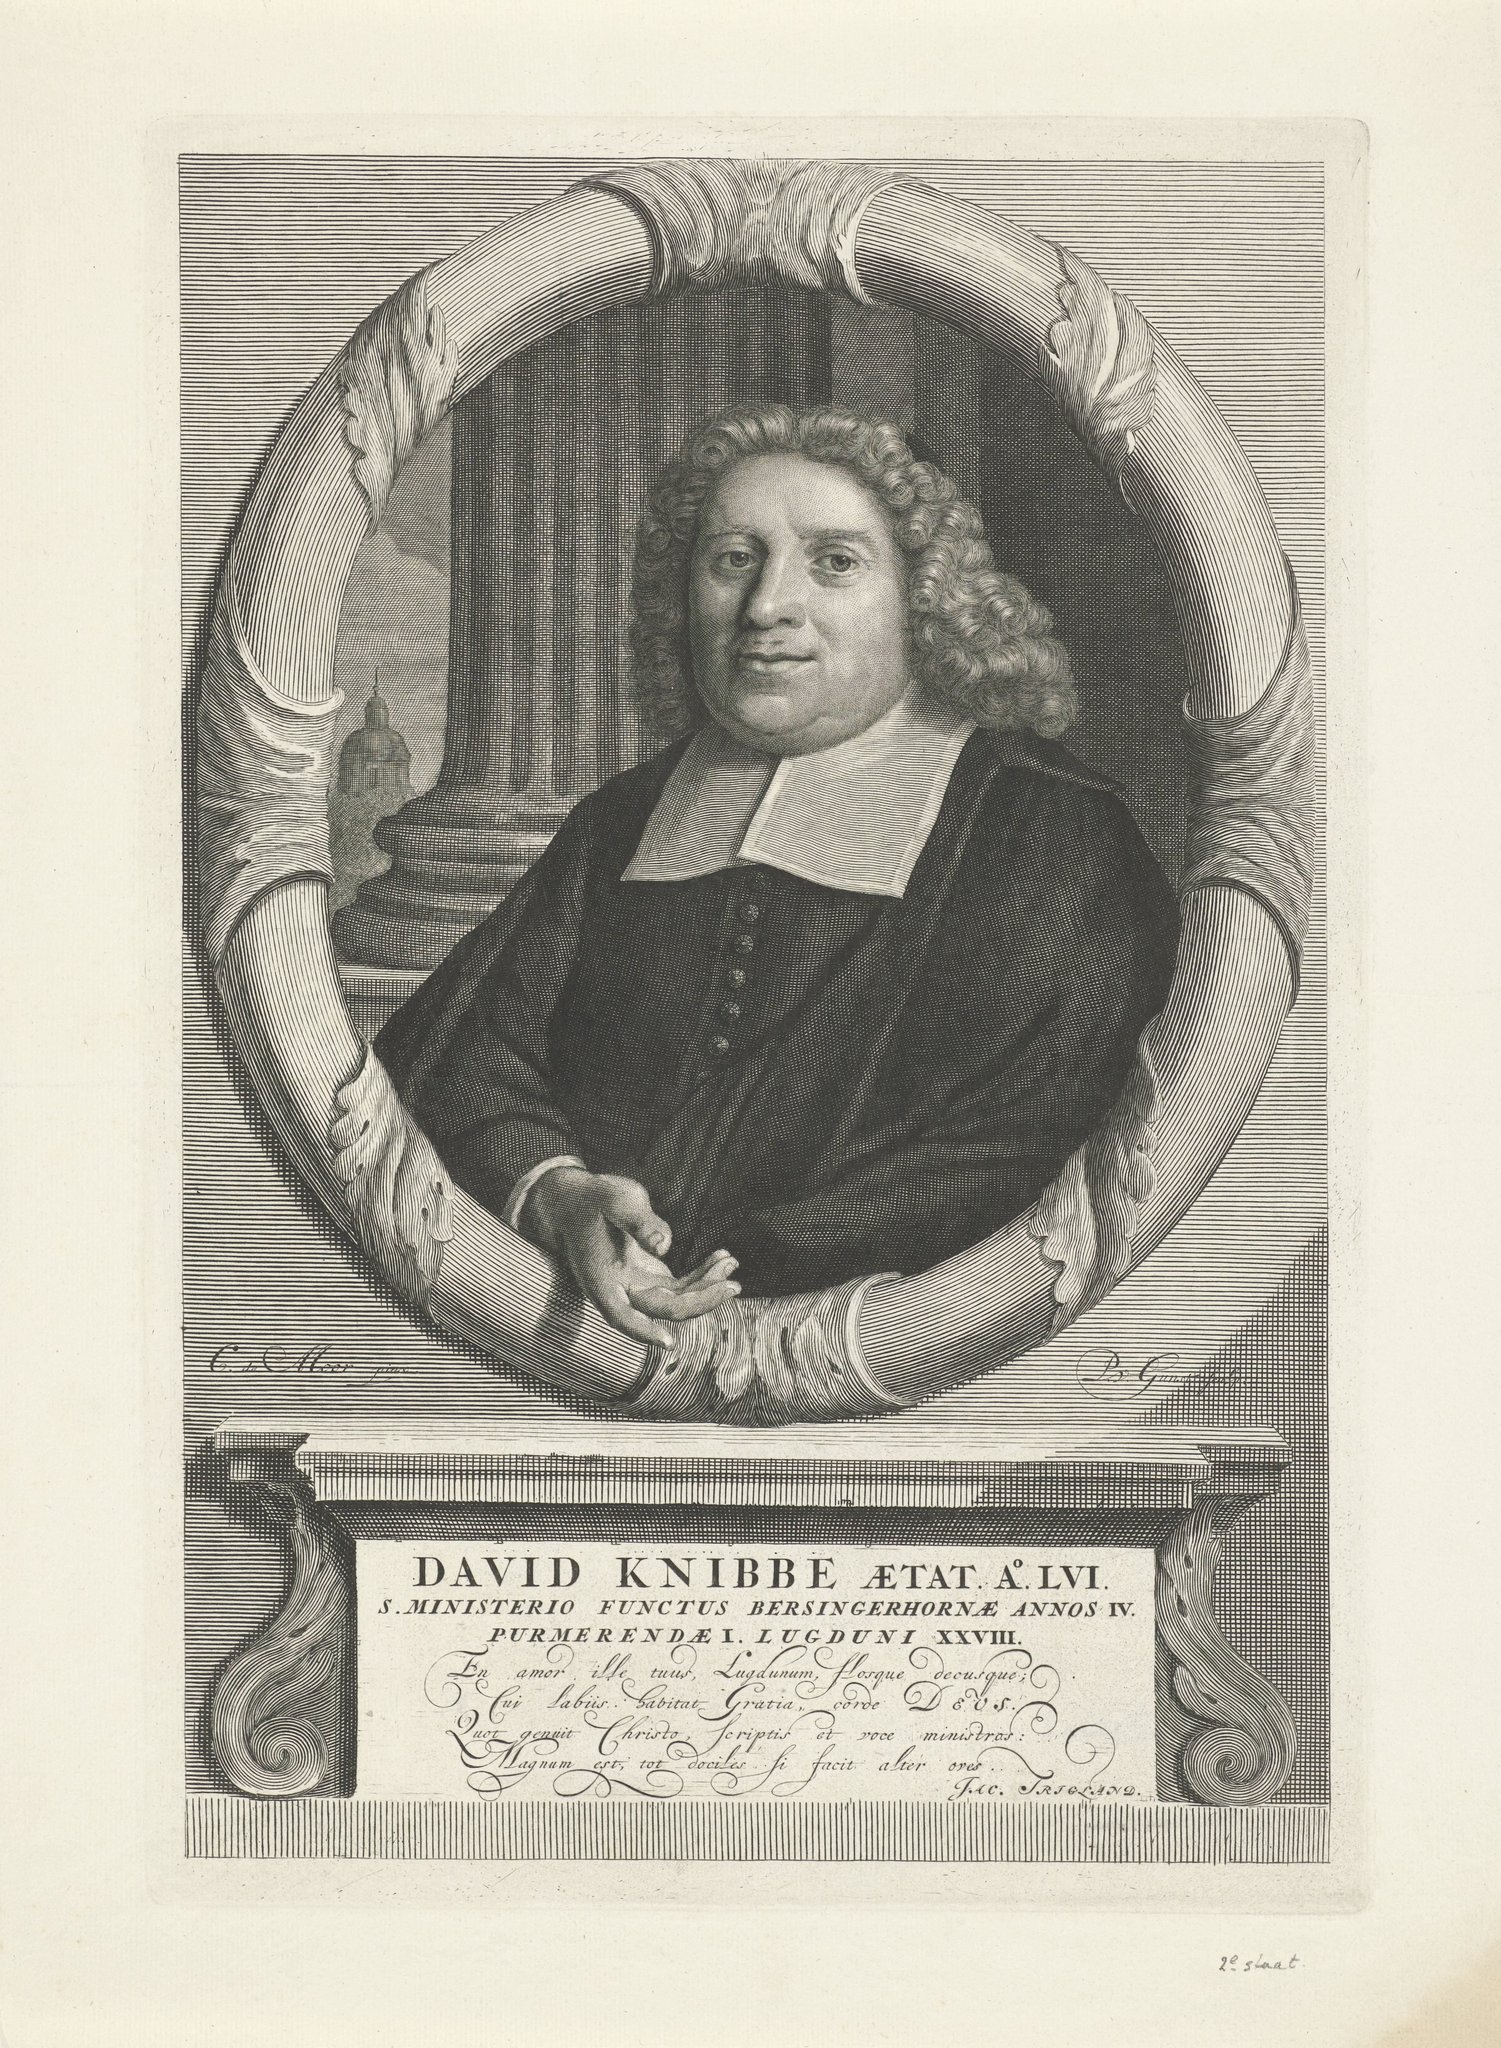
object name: print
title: Portret van David Knibbe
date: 1695-1731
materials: paper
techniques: engraving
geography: amsterdam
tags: predikant, david knibbe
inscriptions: collector's mark: Lugt 2228, collector's mark: Lugt 2233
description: David Knibbe, predikant te Barsingerhoorn, te Purmerend en te Leiden. Op de achtergrond een Romeinse zuil en een kerk. De prent heeft een Latijns onderschrift.